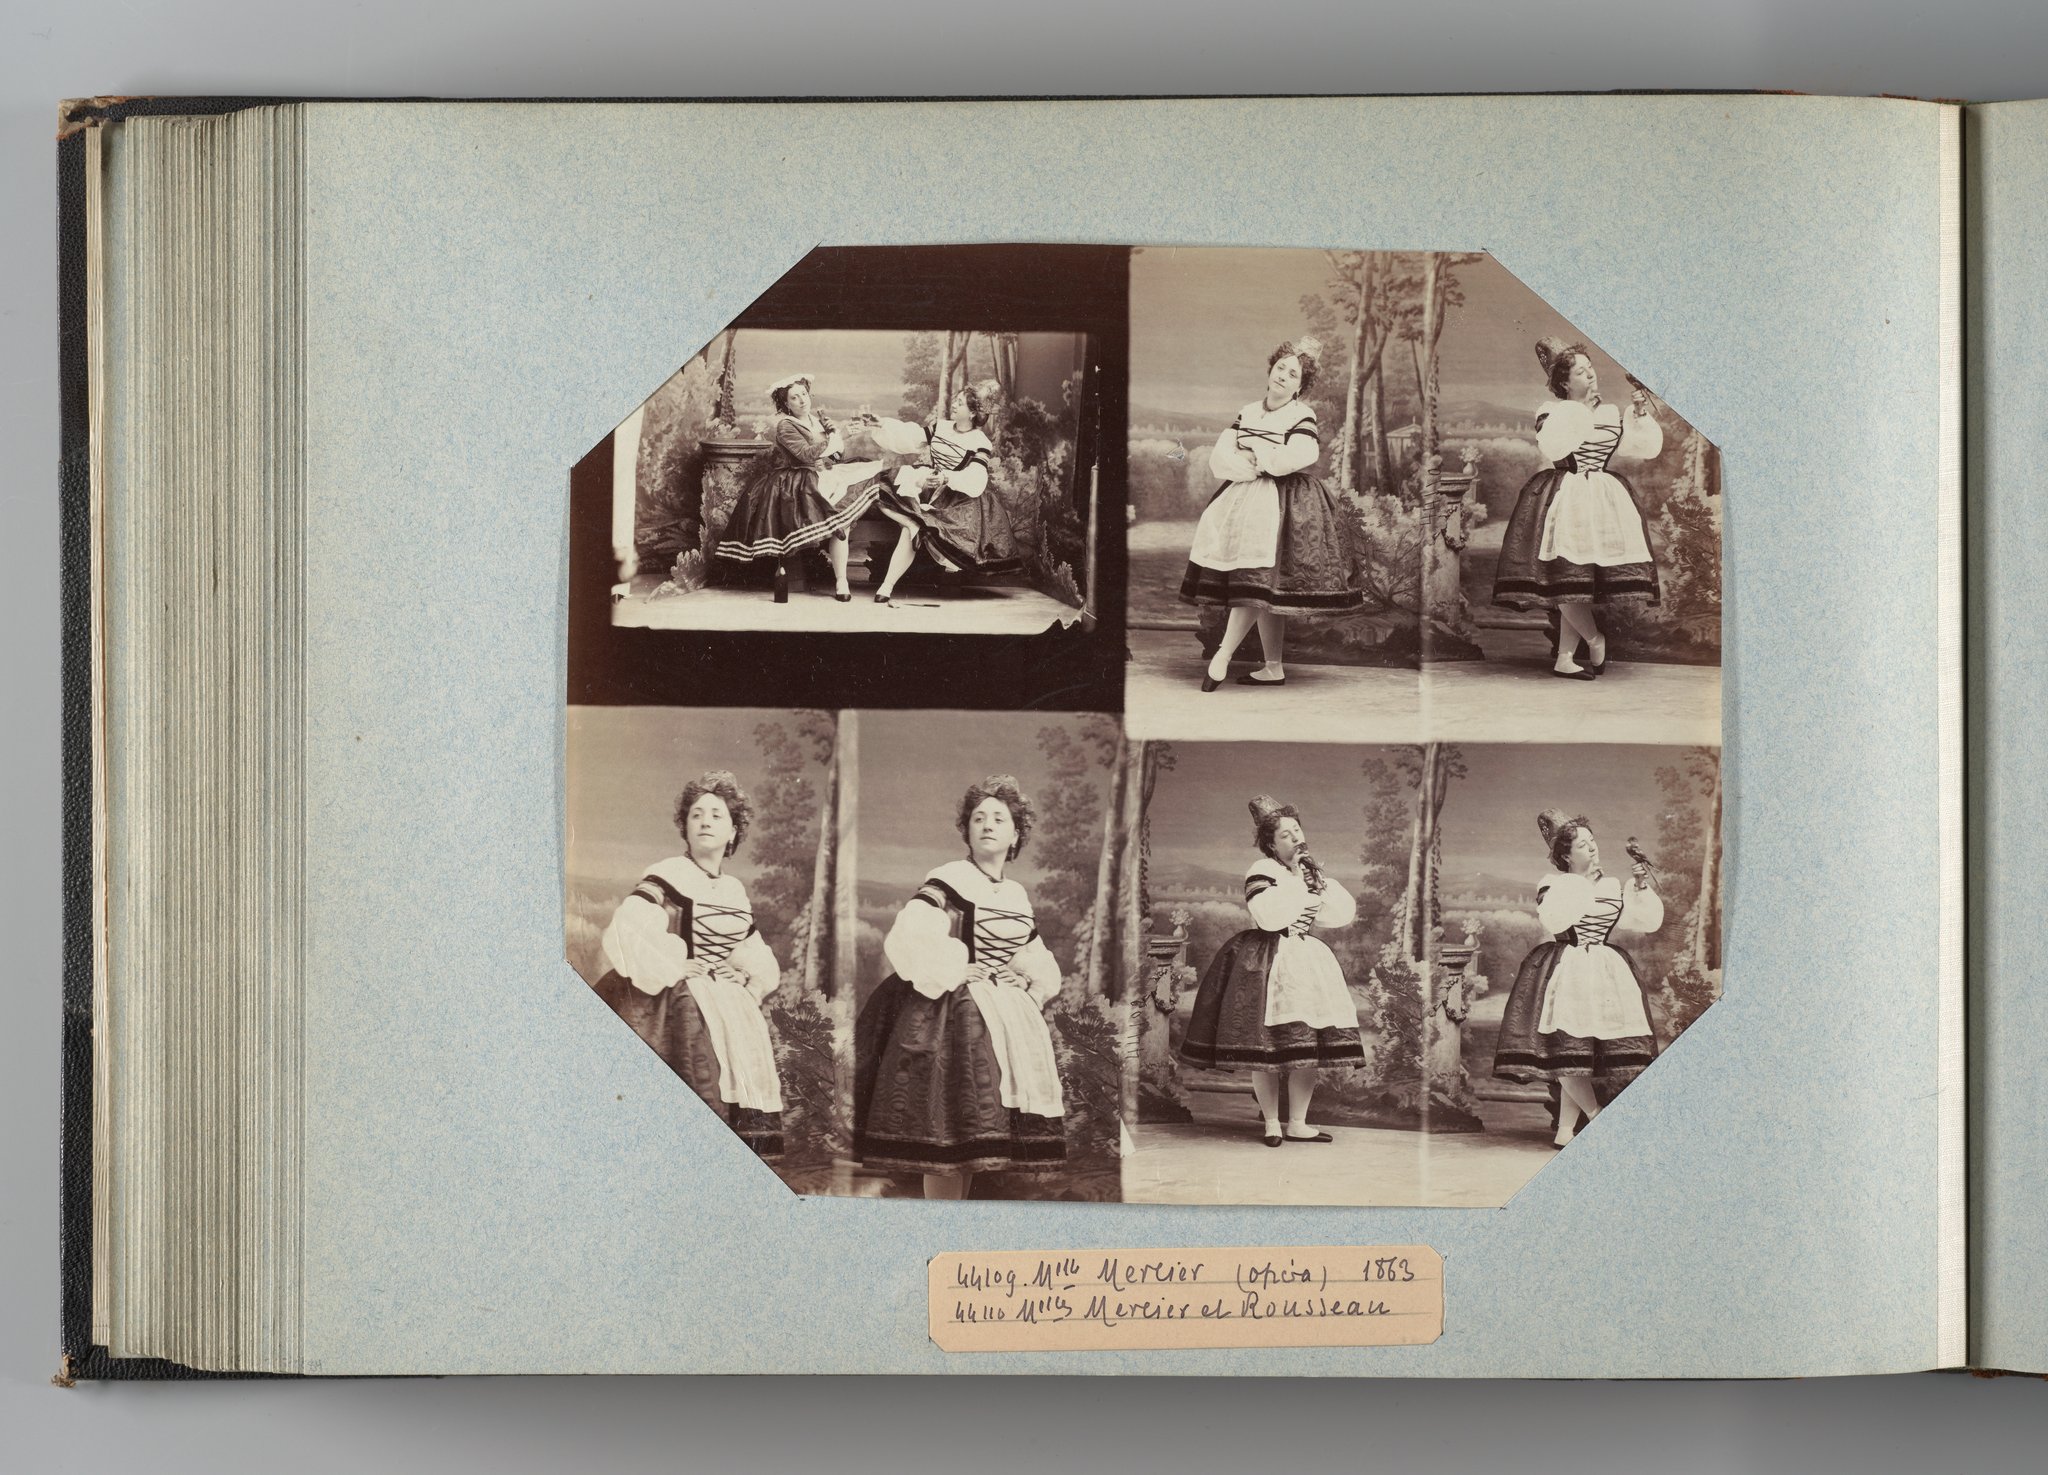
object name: photograph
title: Mlle Mercier; Mlles Mercier et Rousseau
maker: andré-adolphe-eugène disdéri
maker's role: artist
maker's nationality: french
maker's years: 1819-1889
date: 1863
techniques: albumen silver print, glass negative